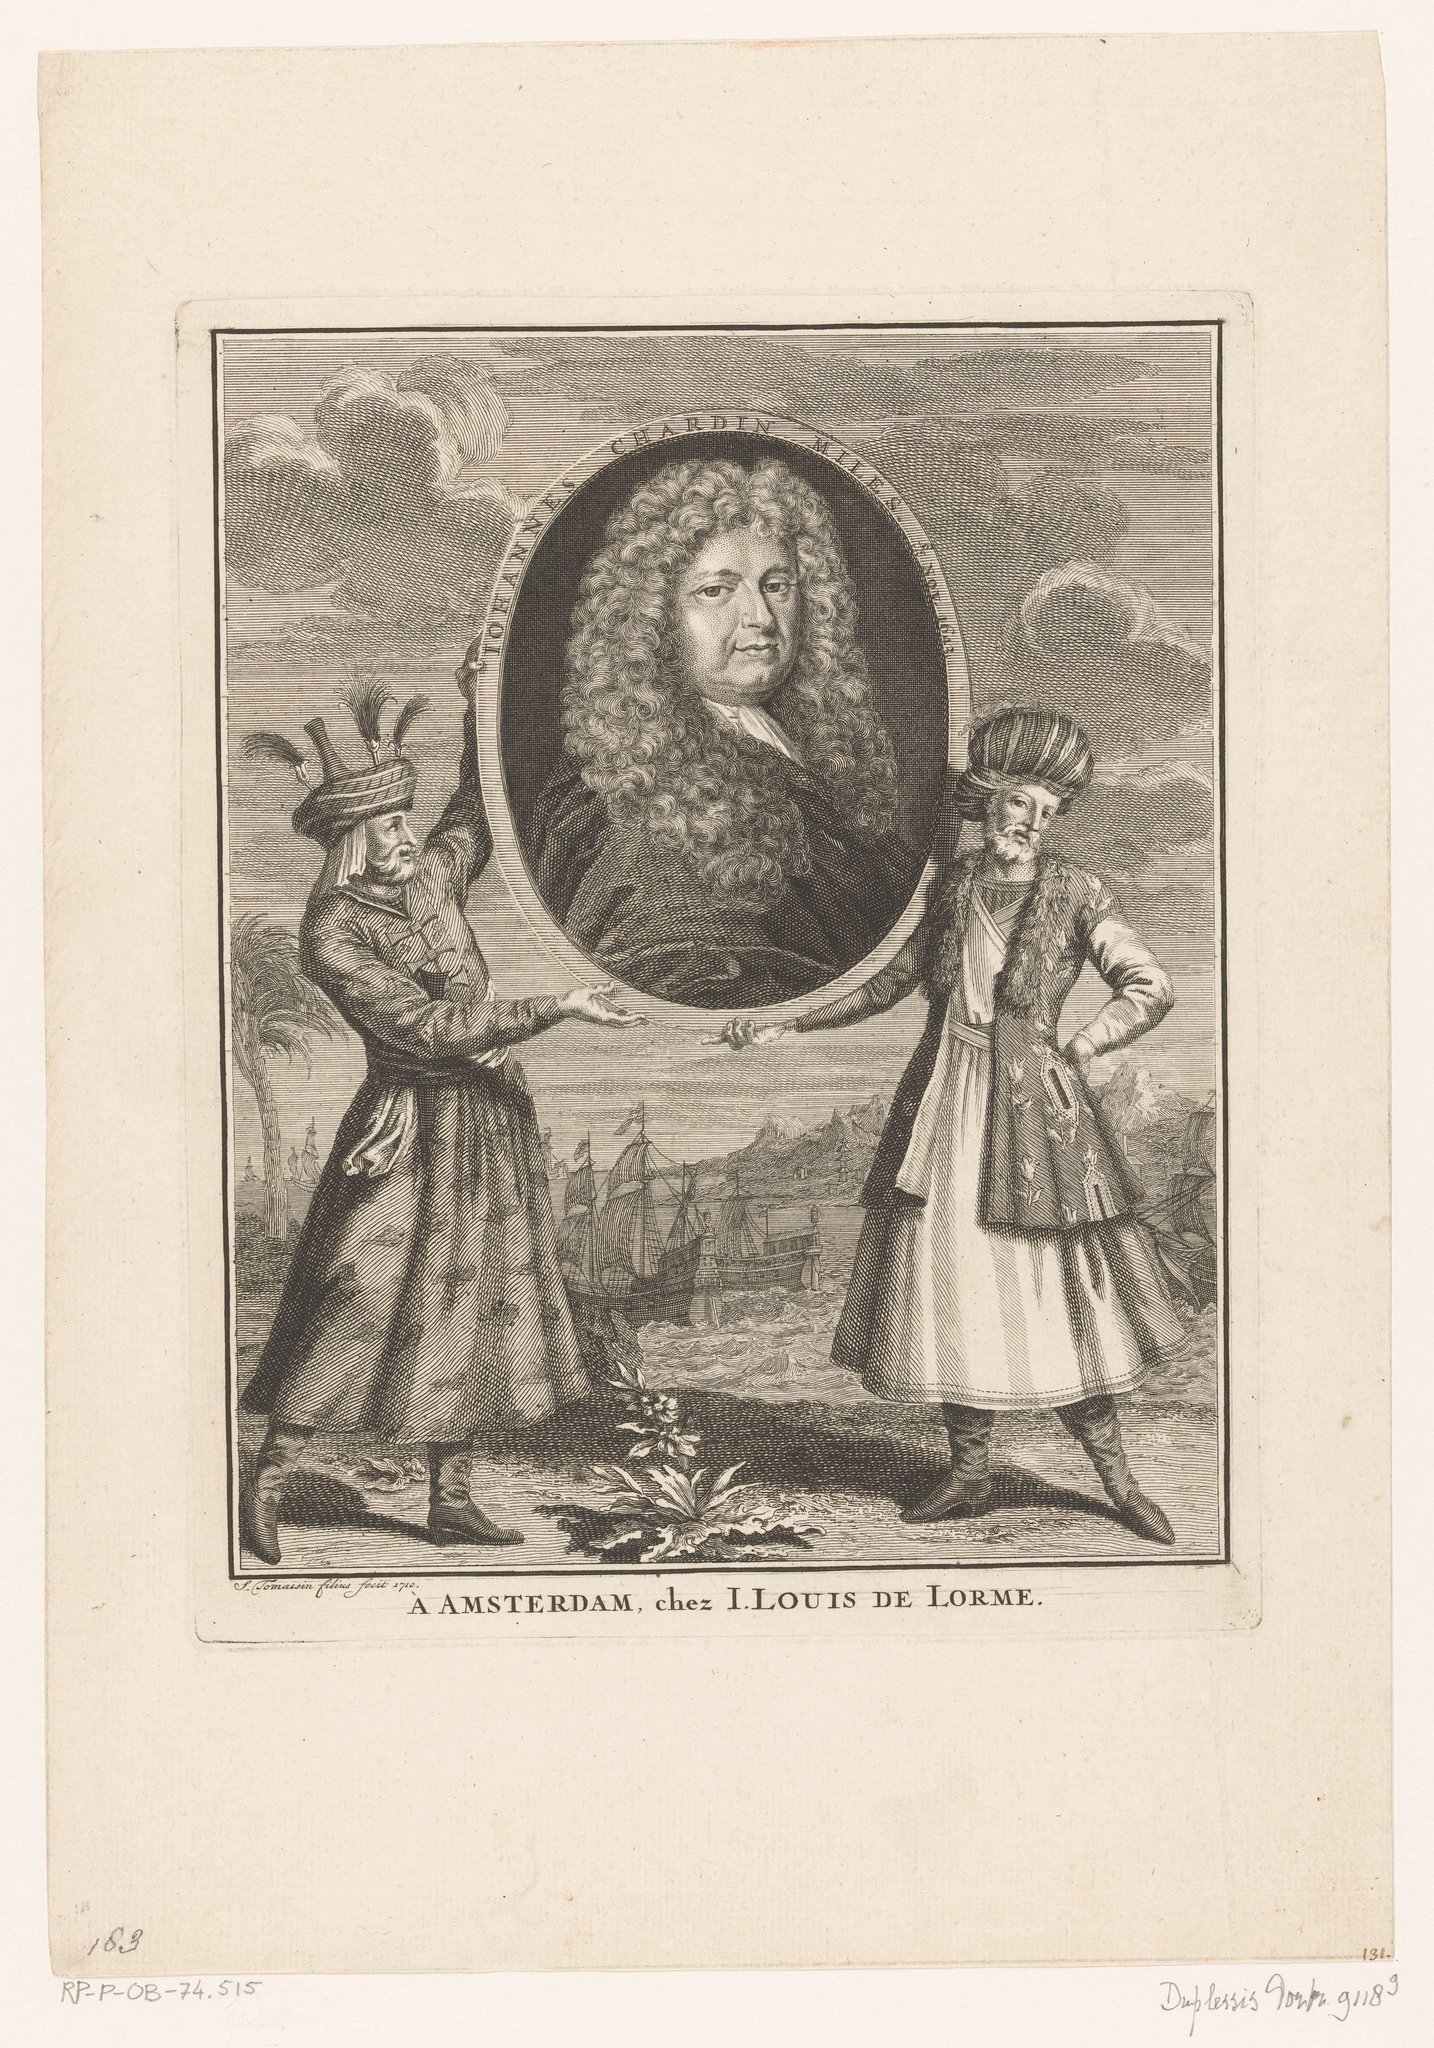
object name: print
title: Portret van Johannes Chardin Miles gedragen door twee mannen in Oosters kostuum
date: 1710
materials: paper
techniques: engraving, etching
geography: amsterdam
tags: paris, london, painter, historical persons, landscapes with waters, waterscapes, seascapes (in the temperate zone), exploration, expedition, voyage of discovery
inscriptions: collector's mark: Lugt 2228, number: ‘131.’